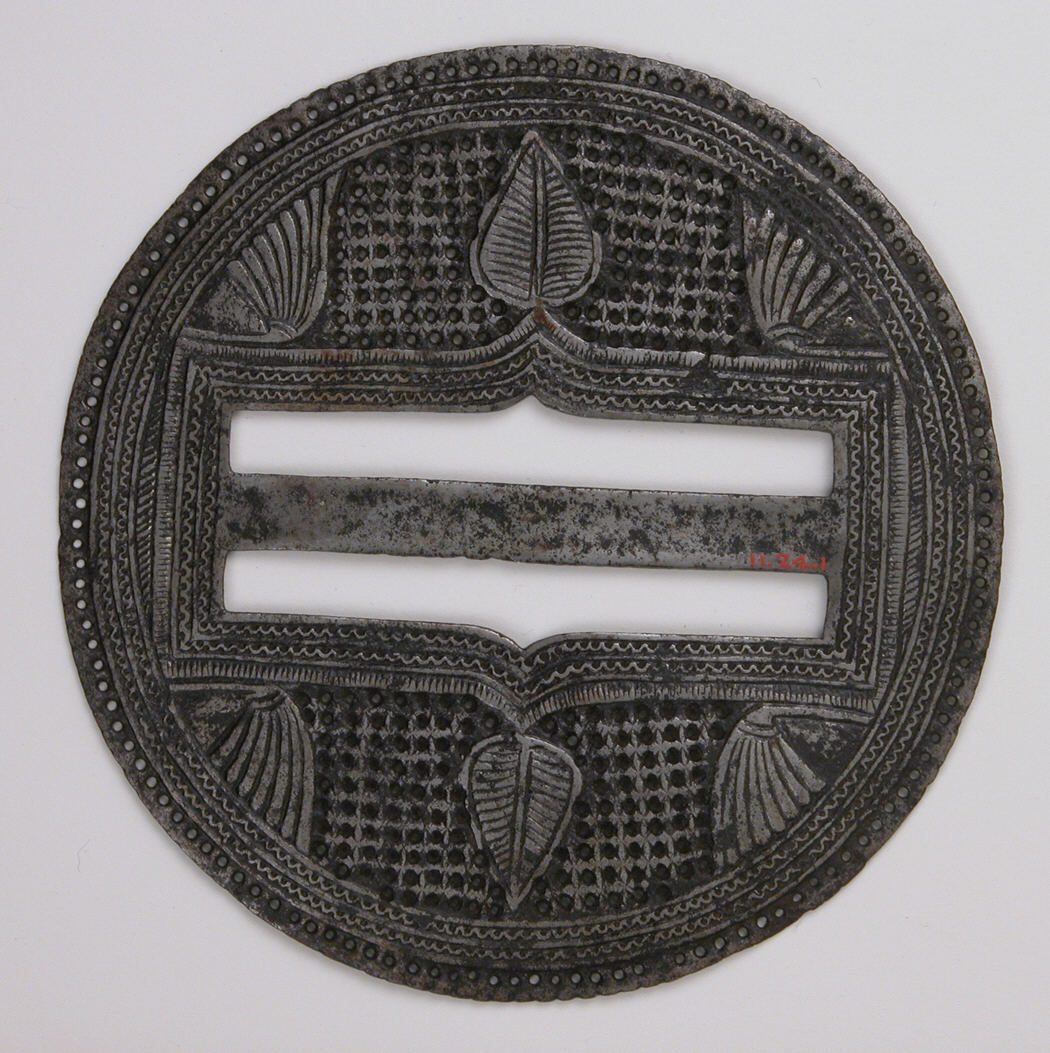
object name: buckle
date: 1601-1700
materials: steel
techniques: gilding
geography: india